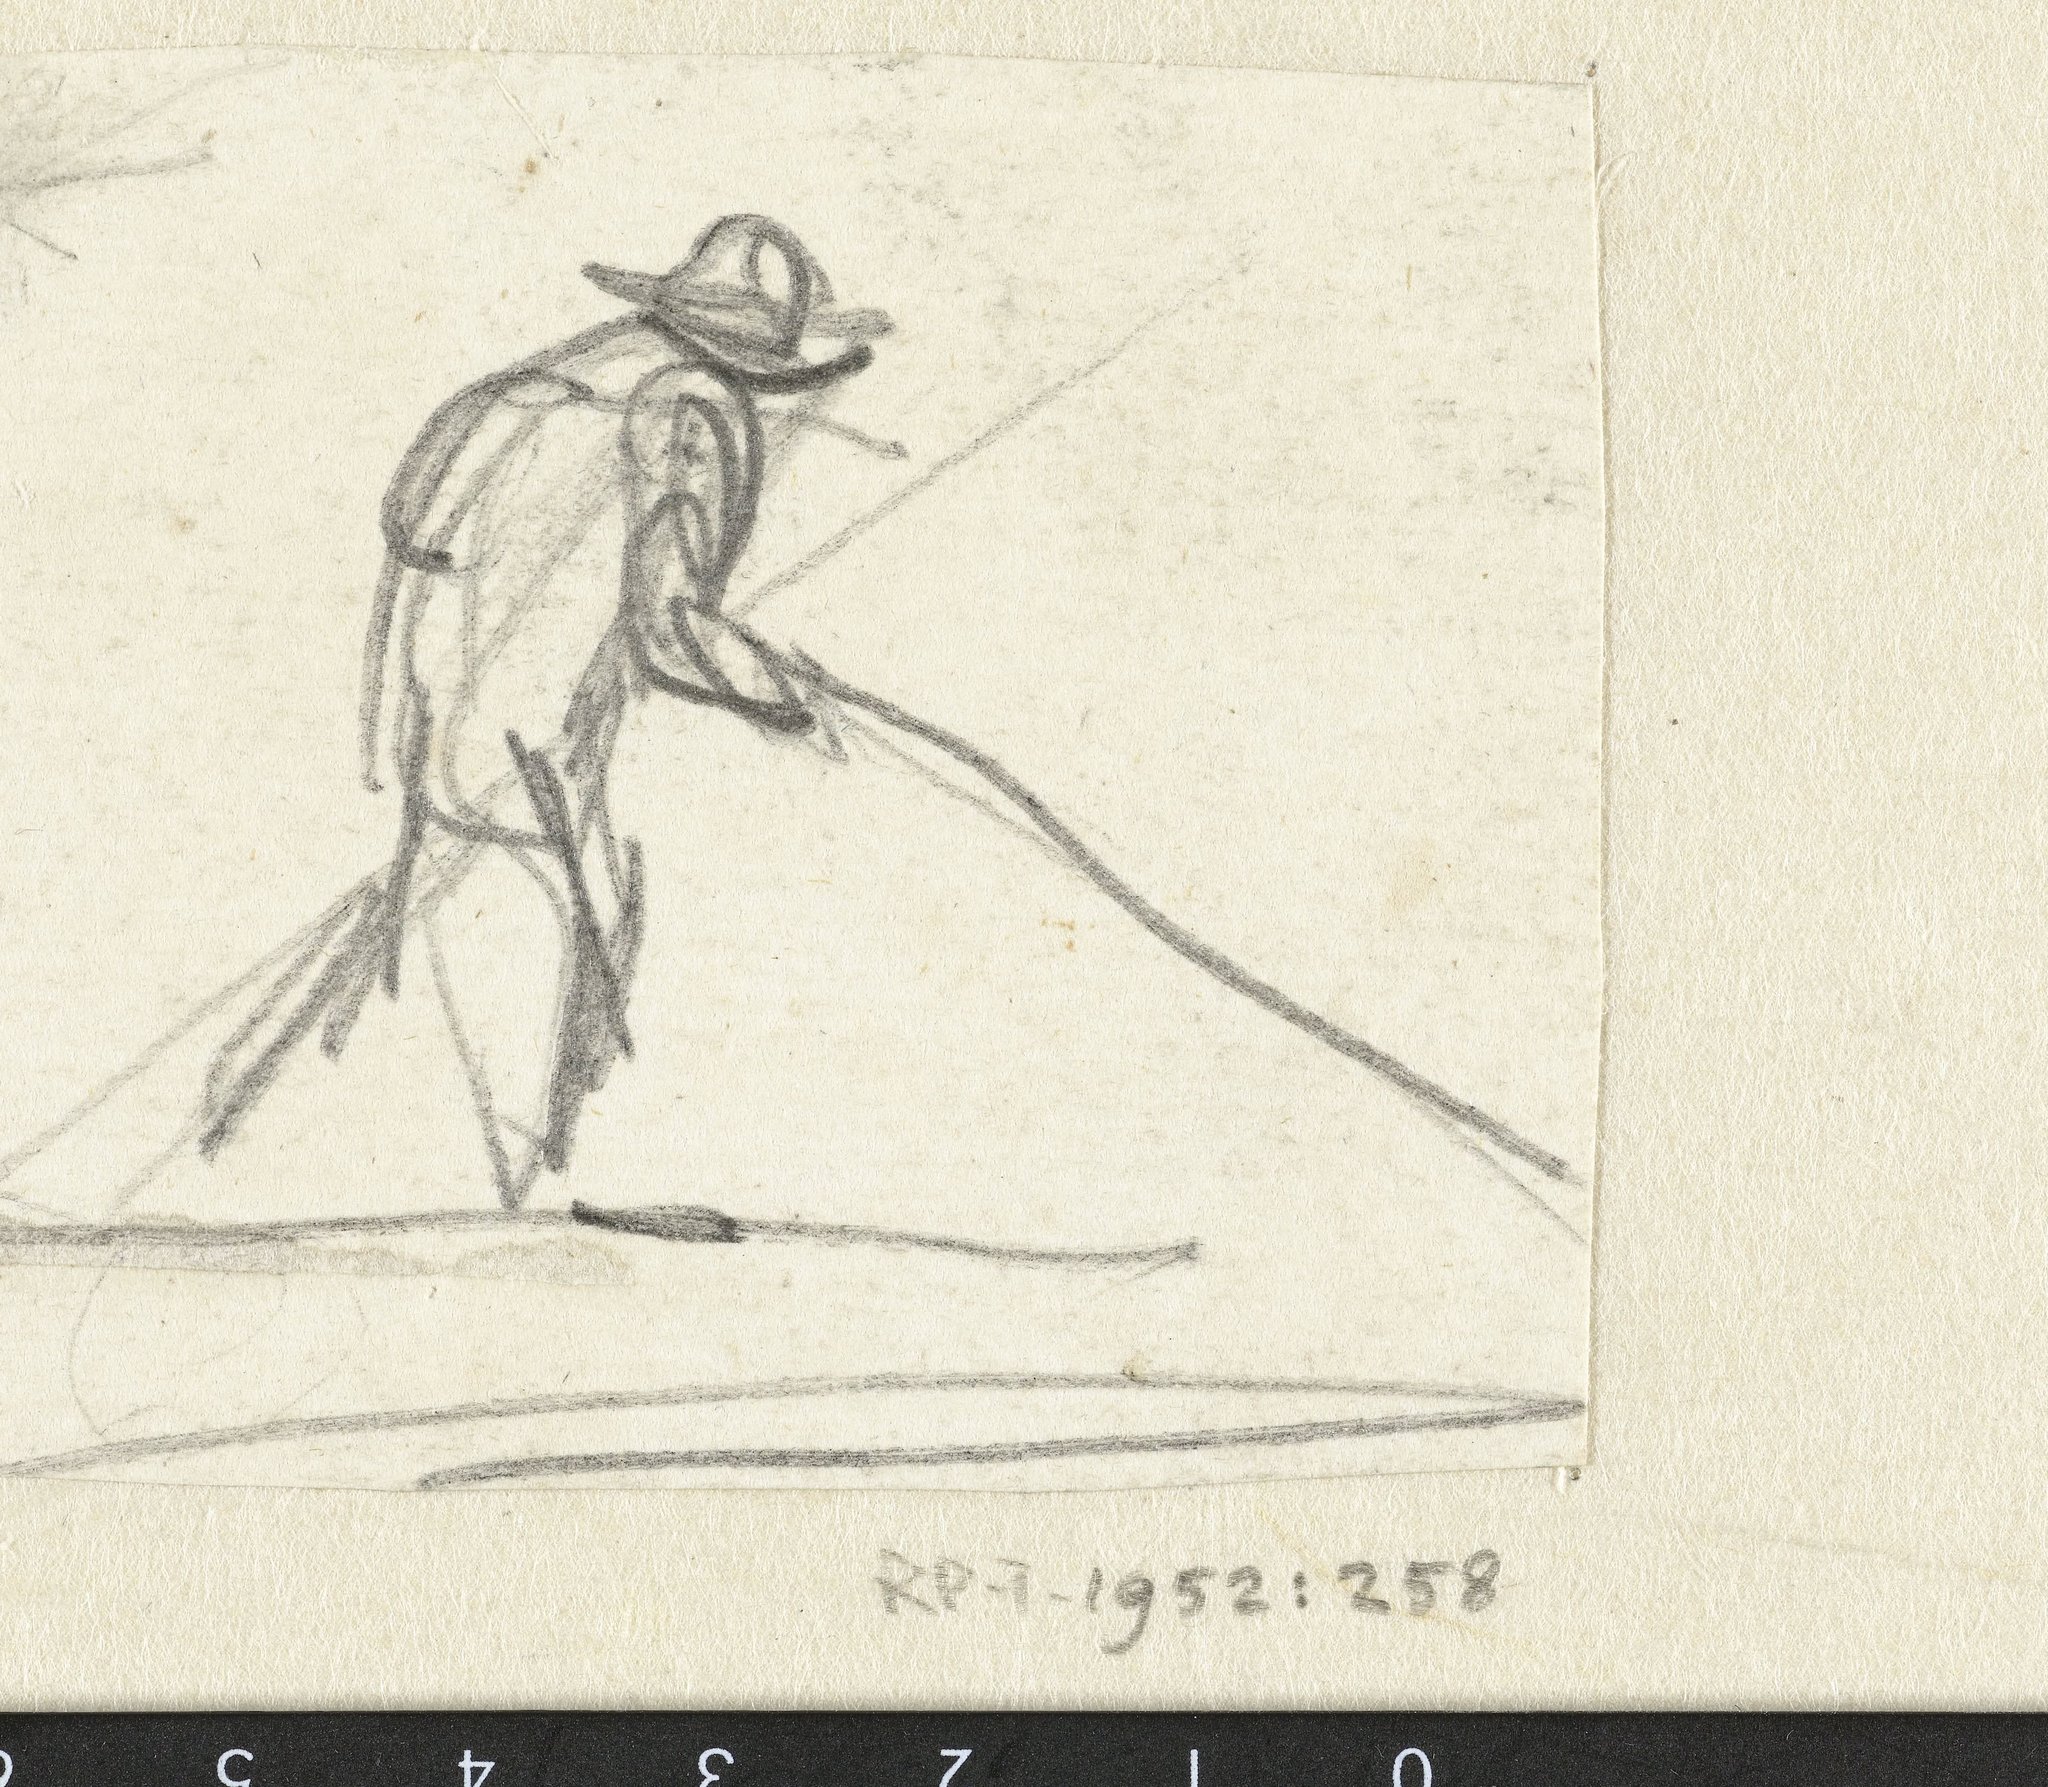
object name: drawing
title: Schetsen van een bomende man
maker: simon andreas krausz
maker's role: draughtsman, print maker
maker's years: 1760-1825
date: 1770-1825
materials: paper, pencil